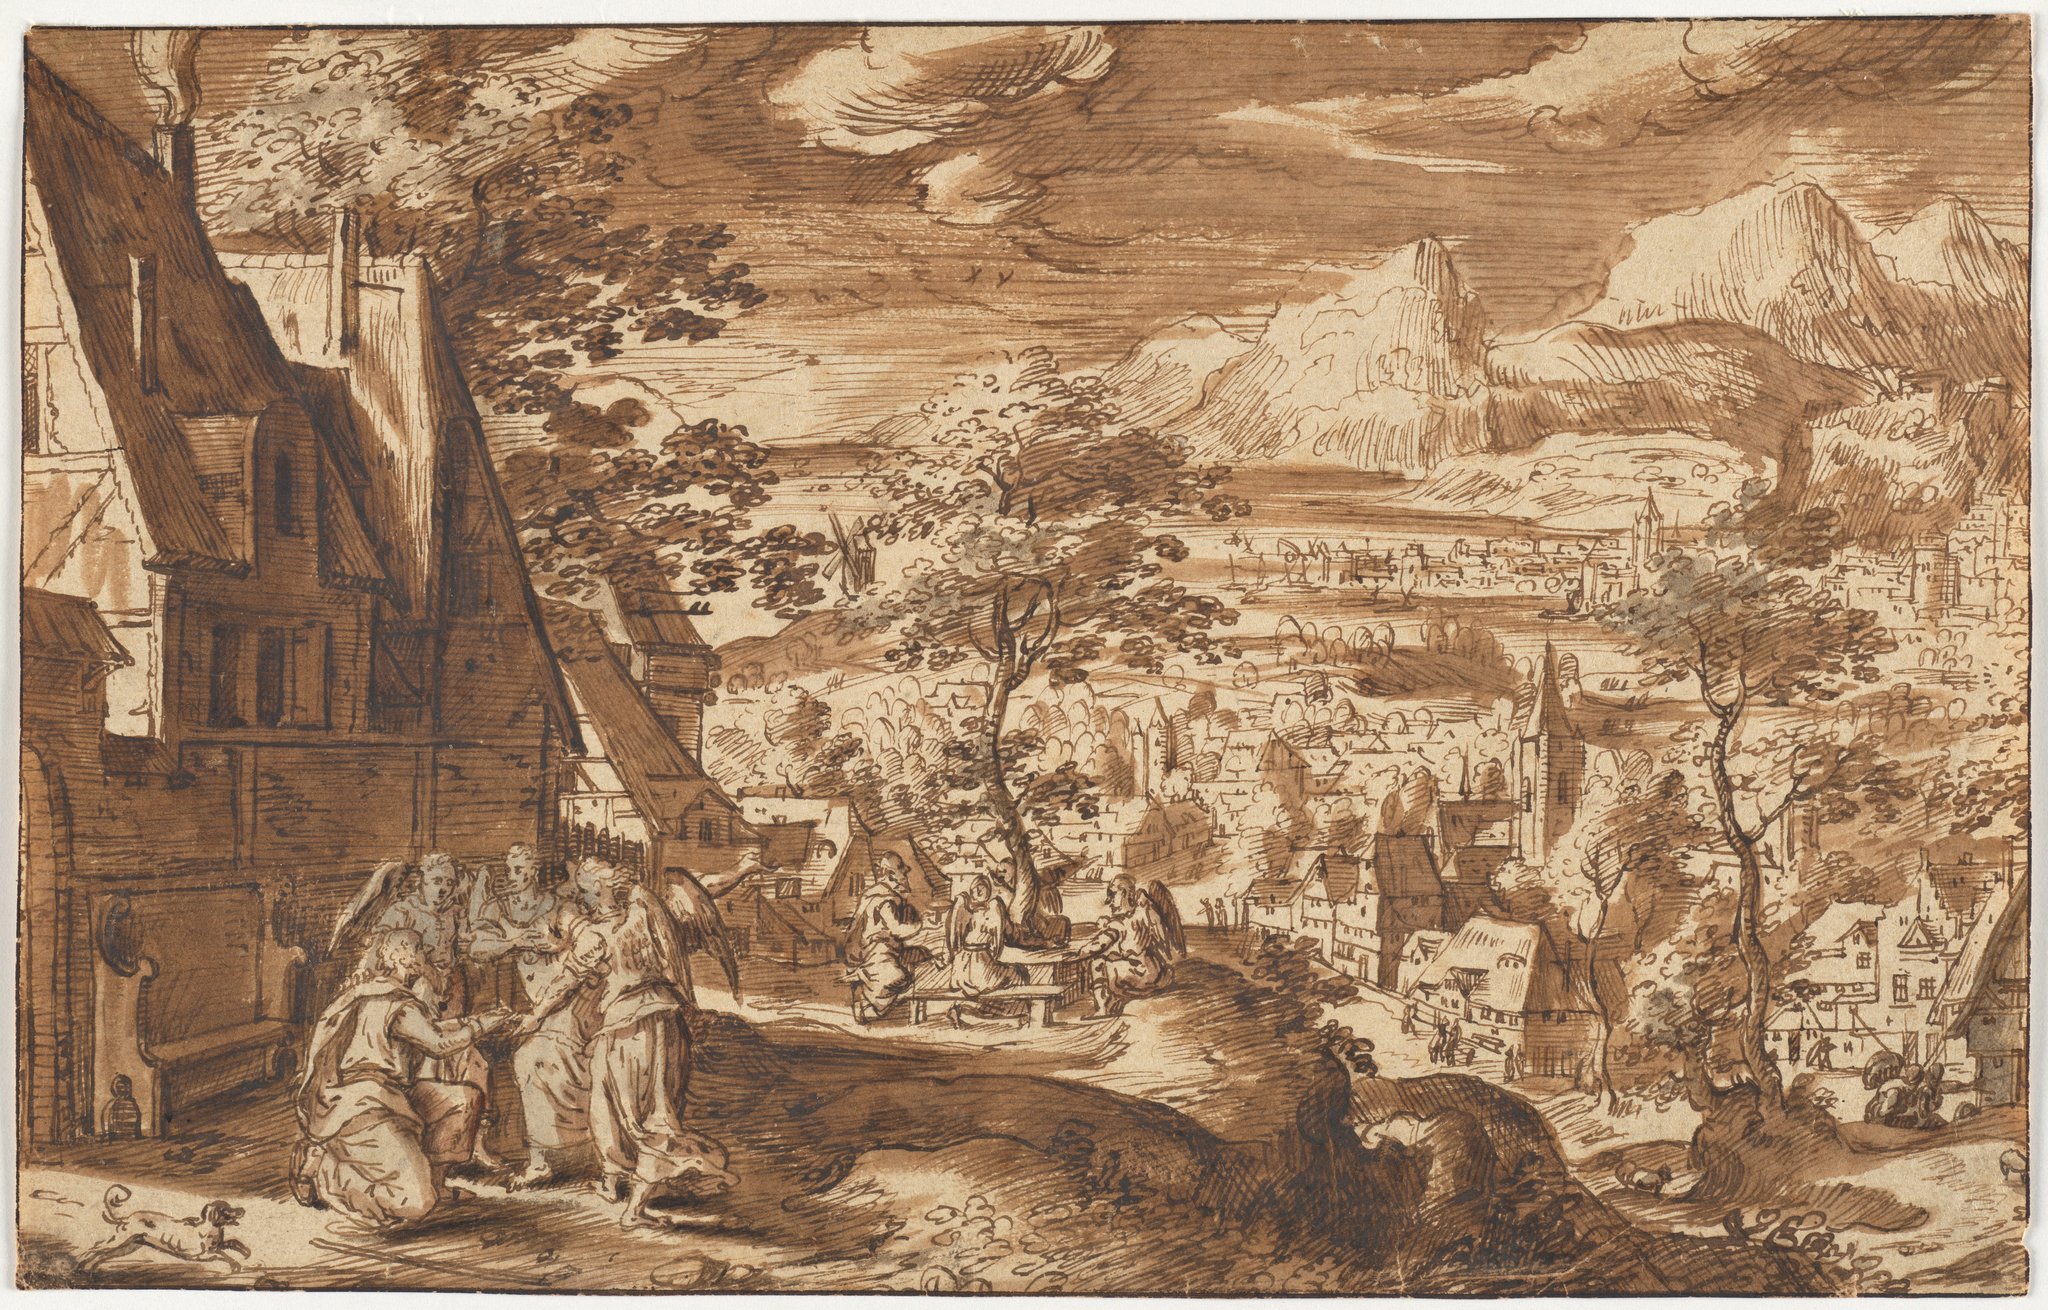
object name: drawing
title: Landscape with Abraham and the Angels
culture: flemish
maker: copy after hans bol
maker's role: artist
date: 1568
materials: ink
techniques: pen, wash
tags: landscapes,angels,abraham